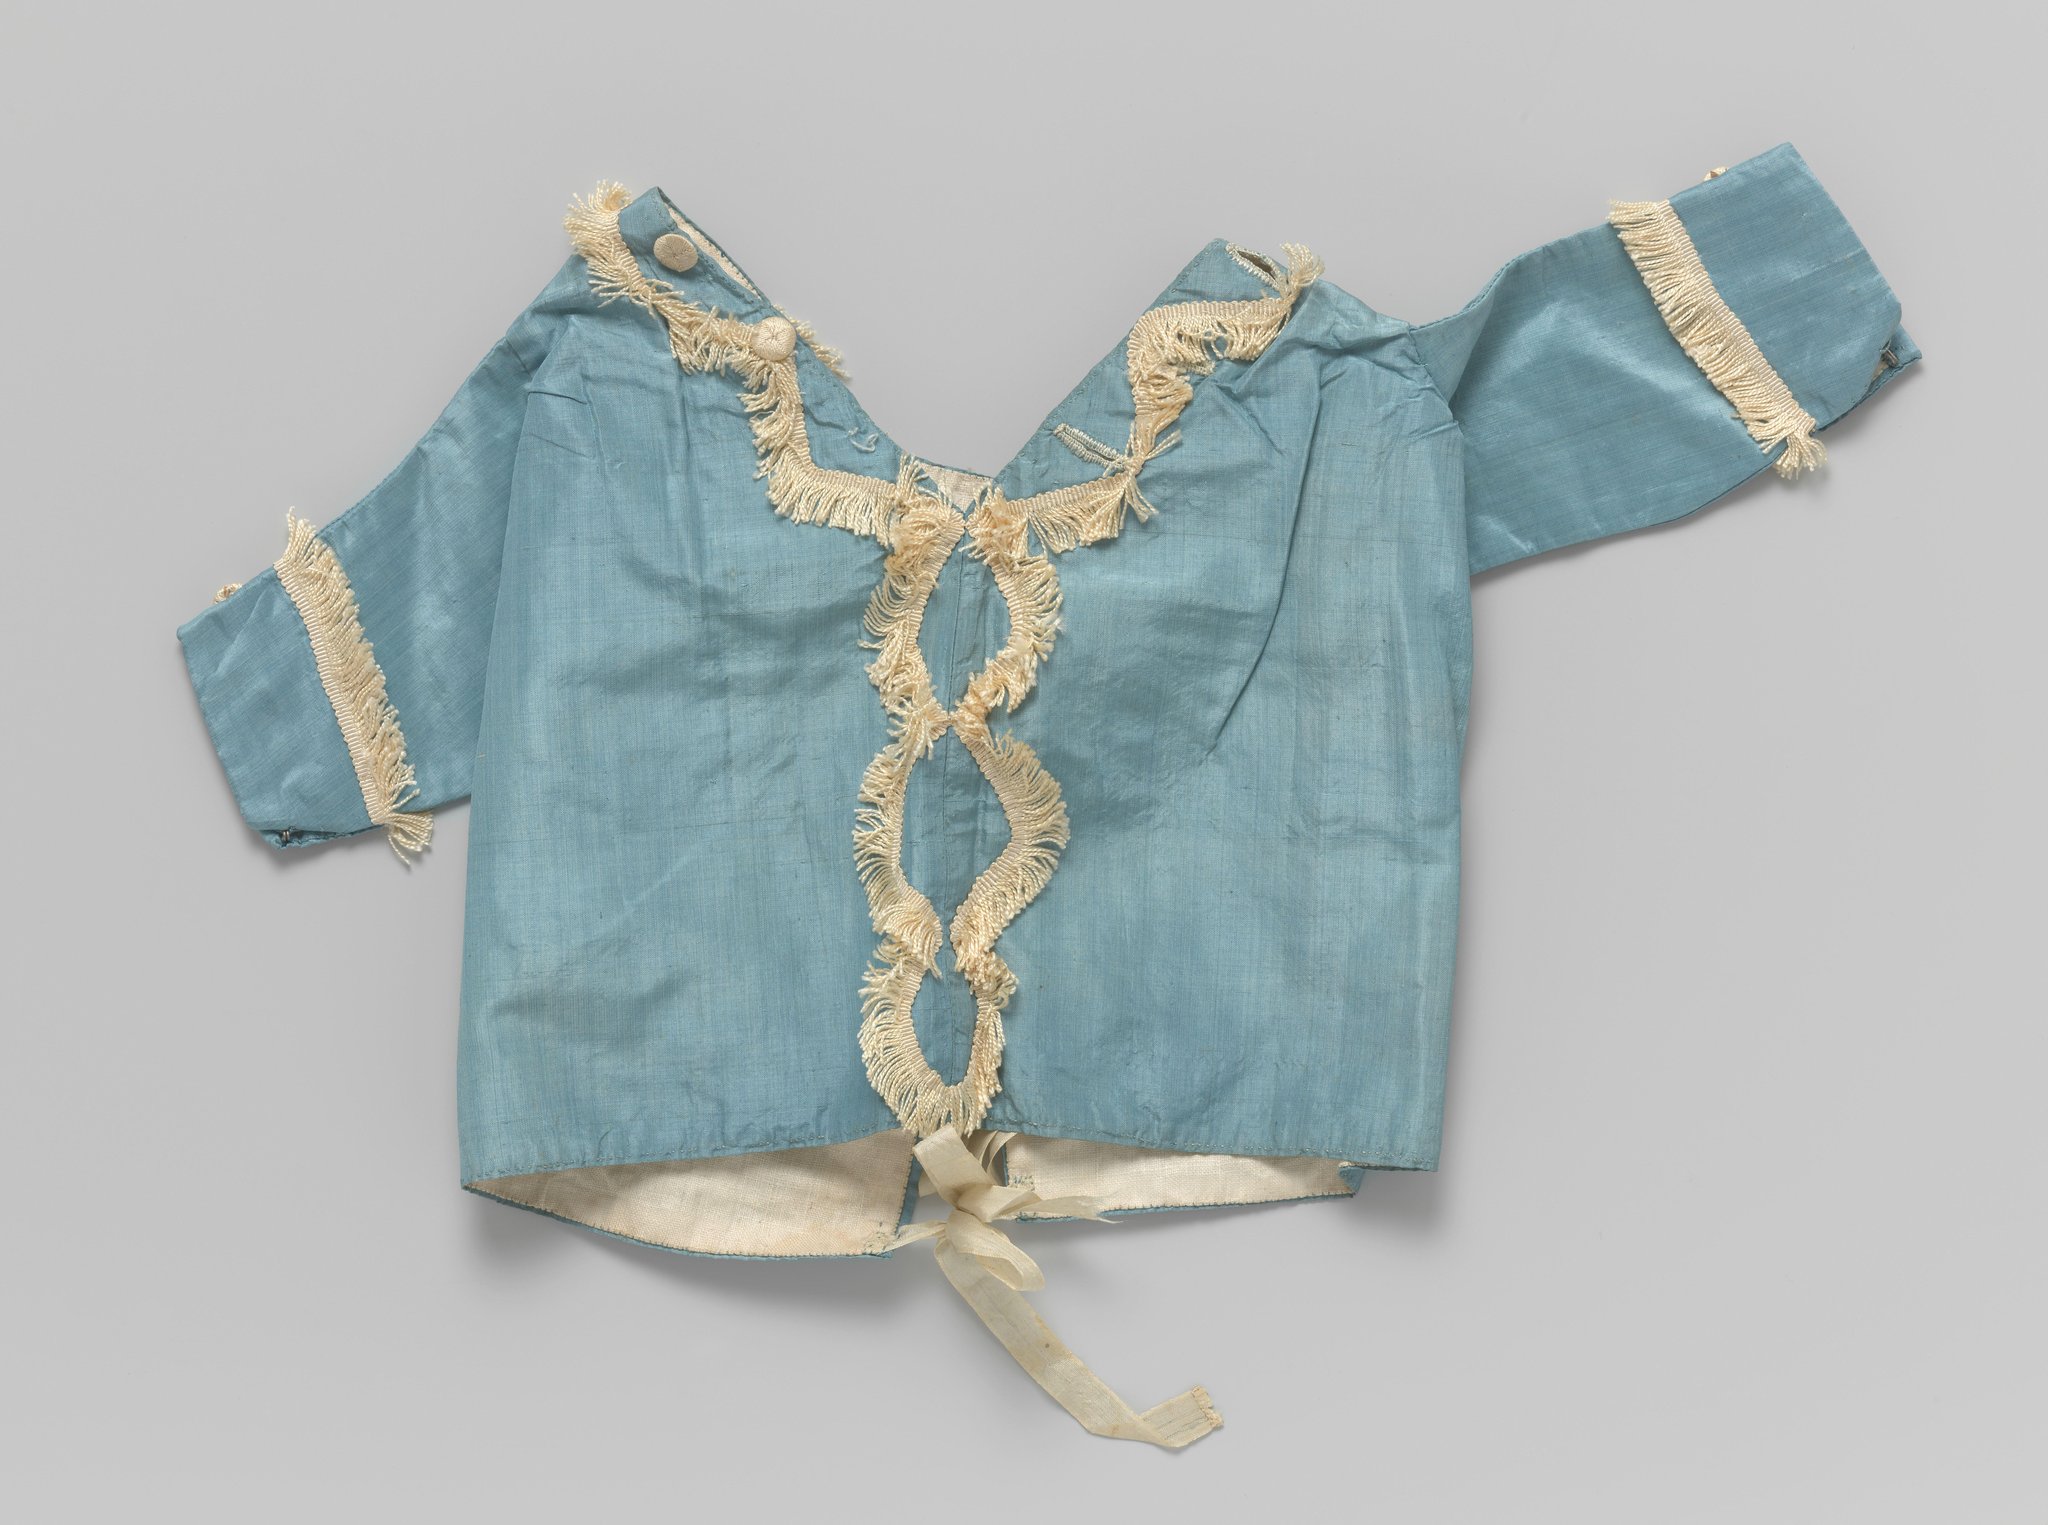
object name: corsage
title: Lijfje van blauwe zijde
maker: Anonymous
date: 1850-1930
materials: silk, textile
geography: europe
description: Lijfje van blauwe zijde met lange mouwen met witte franje langs de kraag en aan de manchetten. Aan elke manchet zitten dri witte knoopjes. Op de rug sluit het lijfje met drie witte strikken van lint. Het lijfje is wit gevoerd.